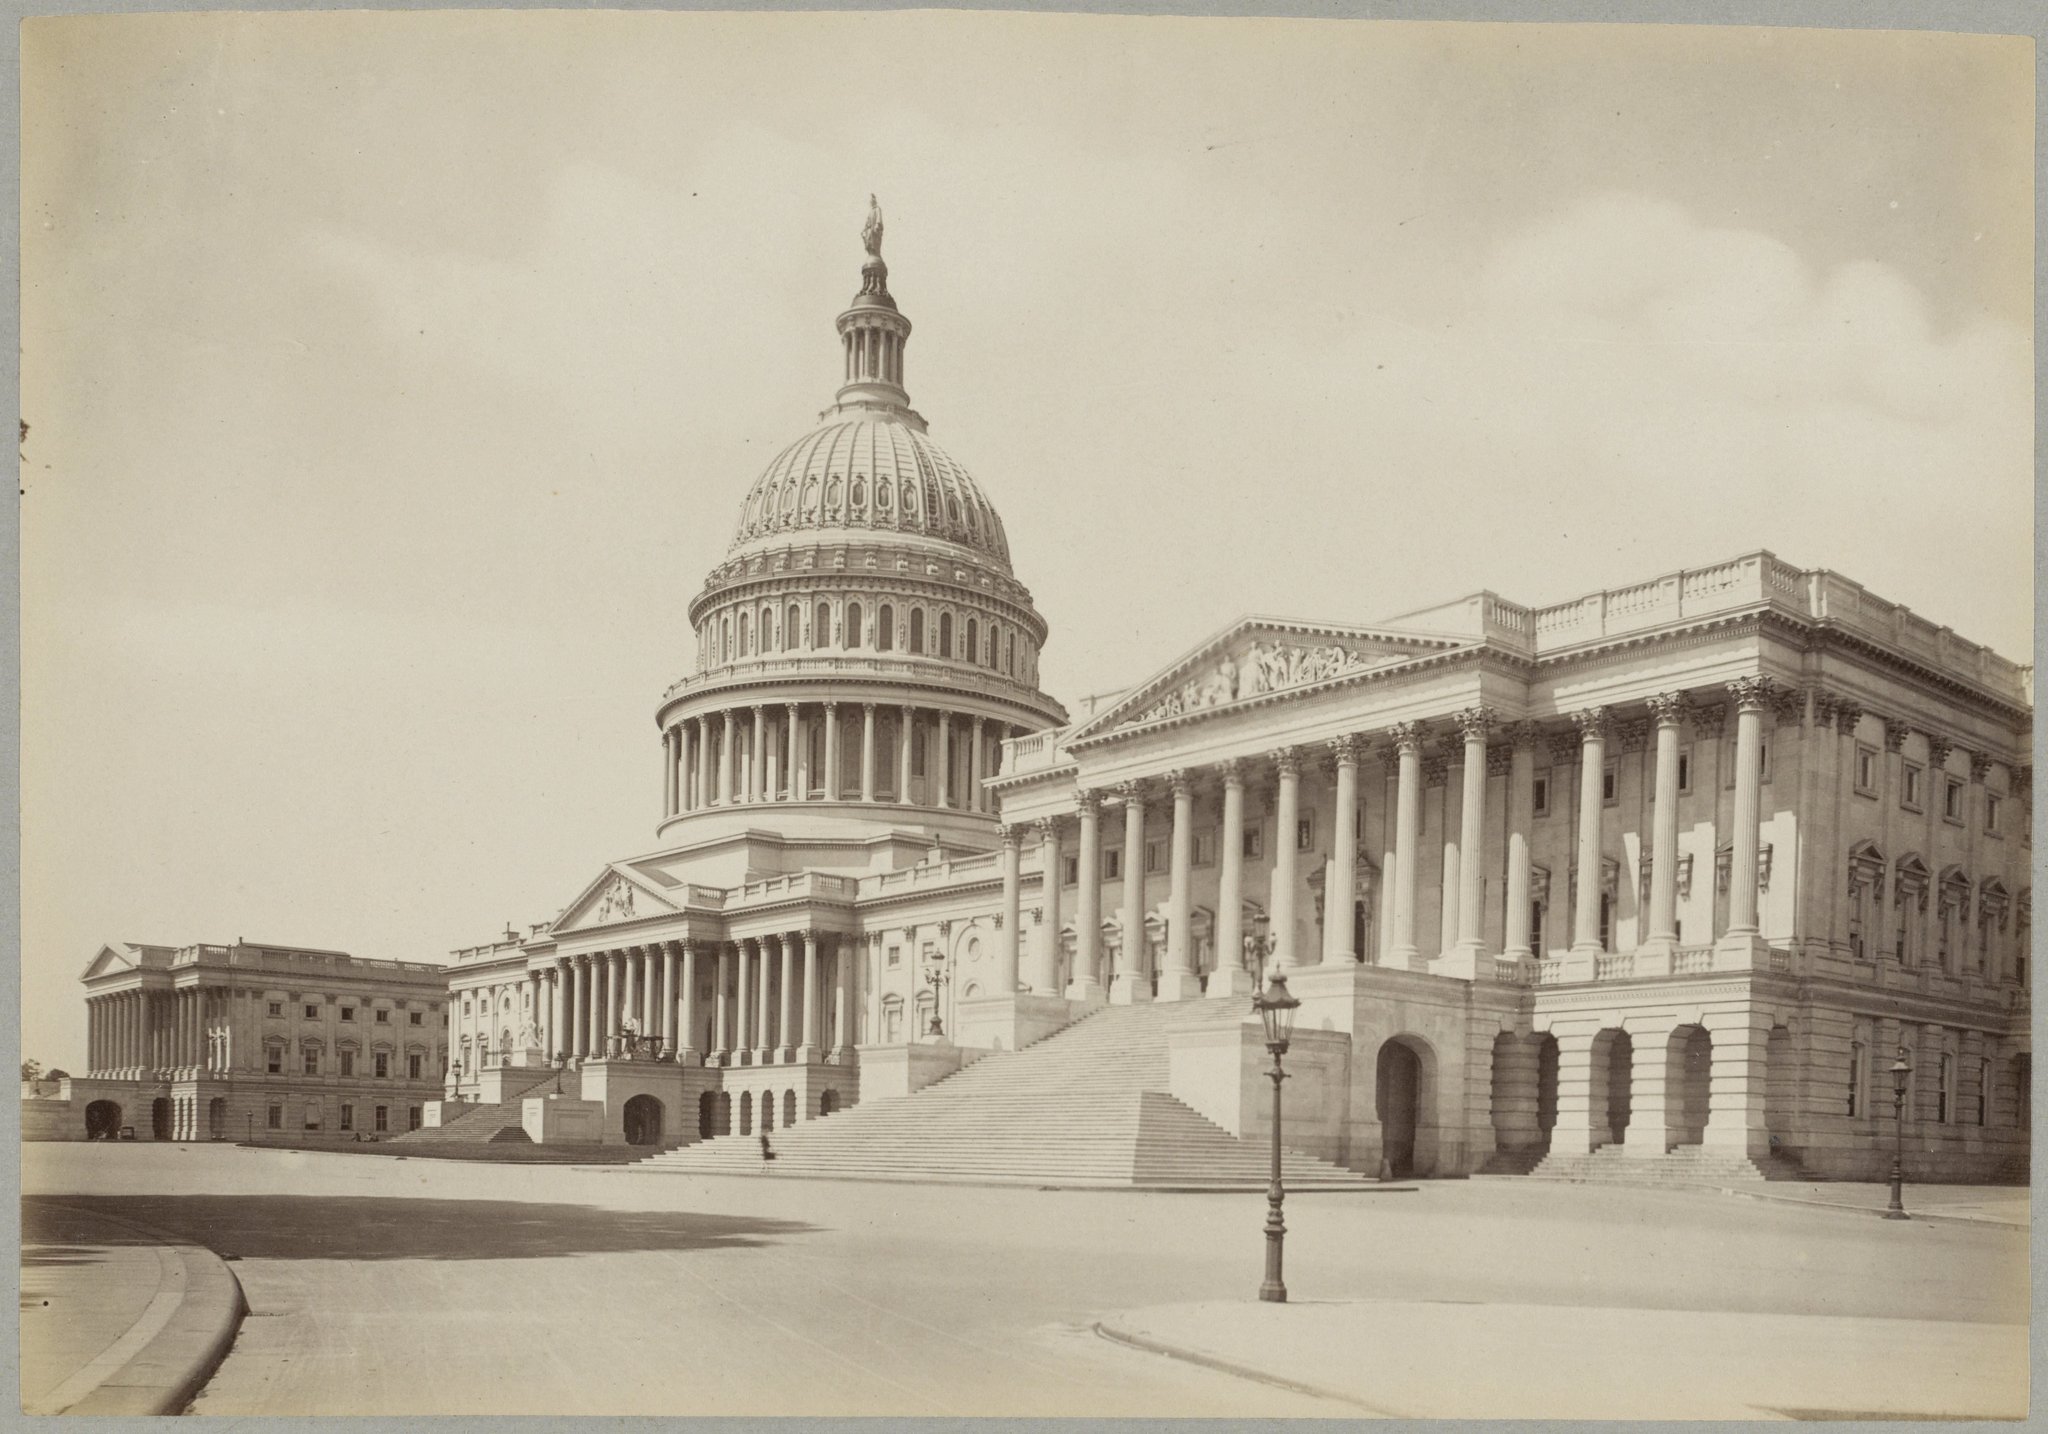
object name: photograph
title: Gezicht op de oostzijde en de koepel van het Capitool in Washington D.C.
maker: Anonymous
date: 1880-1900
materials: cardboard, paper, photographic support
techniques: albumen print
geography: washington d.c.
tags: dome ~ architecture